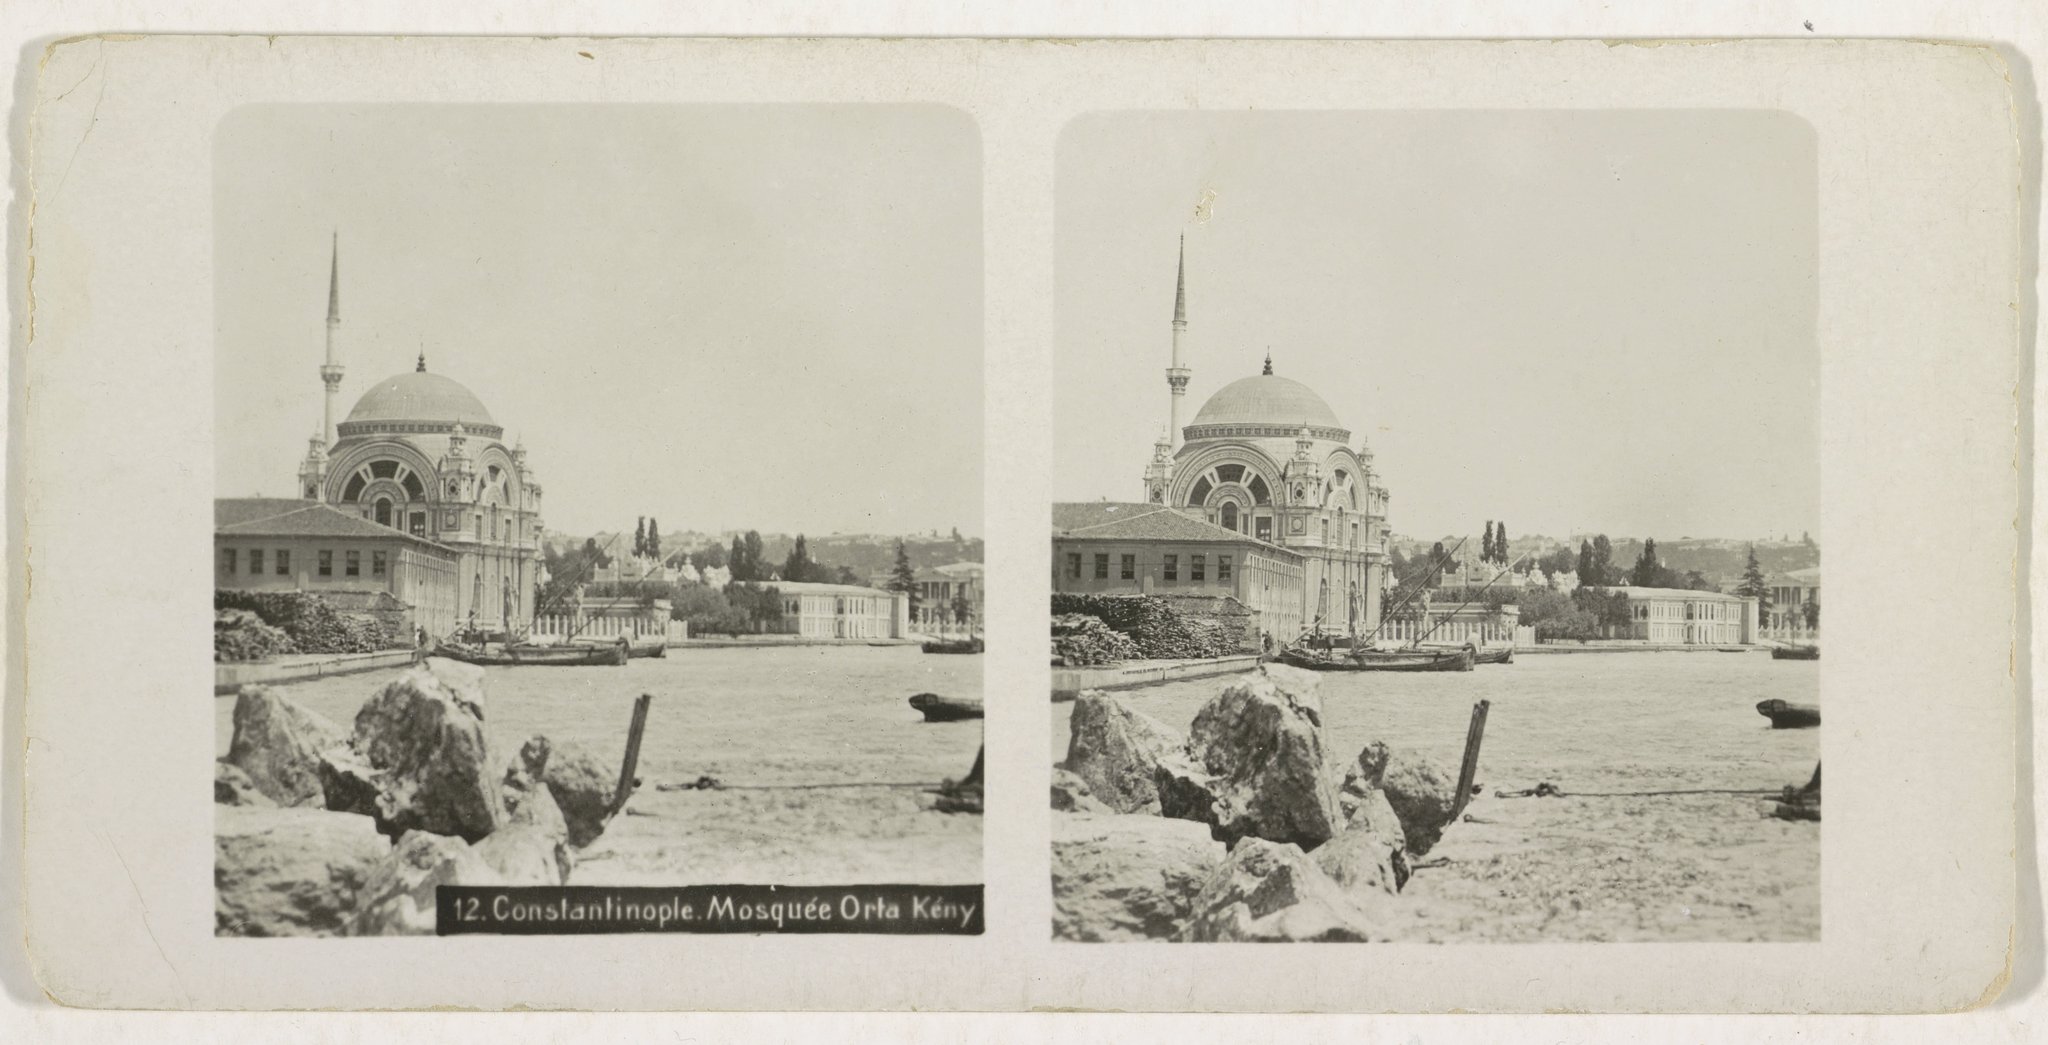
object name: stereograph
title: Dolmabahçe moskee in Istanboel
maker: Anonymous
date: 1903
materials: paper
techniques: gelatin silver print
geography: haarlem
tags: temple, shrine ~ islam, mohammedanism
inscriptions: inscription: ‘Déposée.’, inscription: ‘Deze stereo-foto's worden in den handel gebracht en en gros en/ en détail verkocht door de ......... (...)’, number: ‘12.’, monogram, address: ‘Parklaan 49/ HAARLEM/ (Holland)’